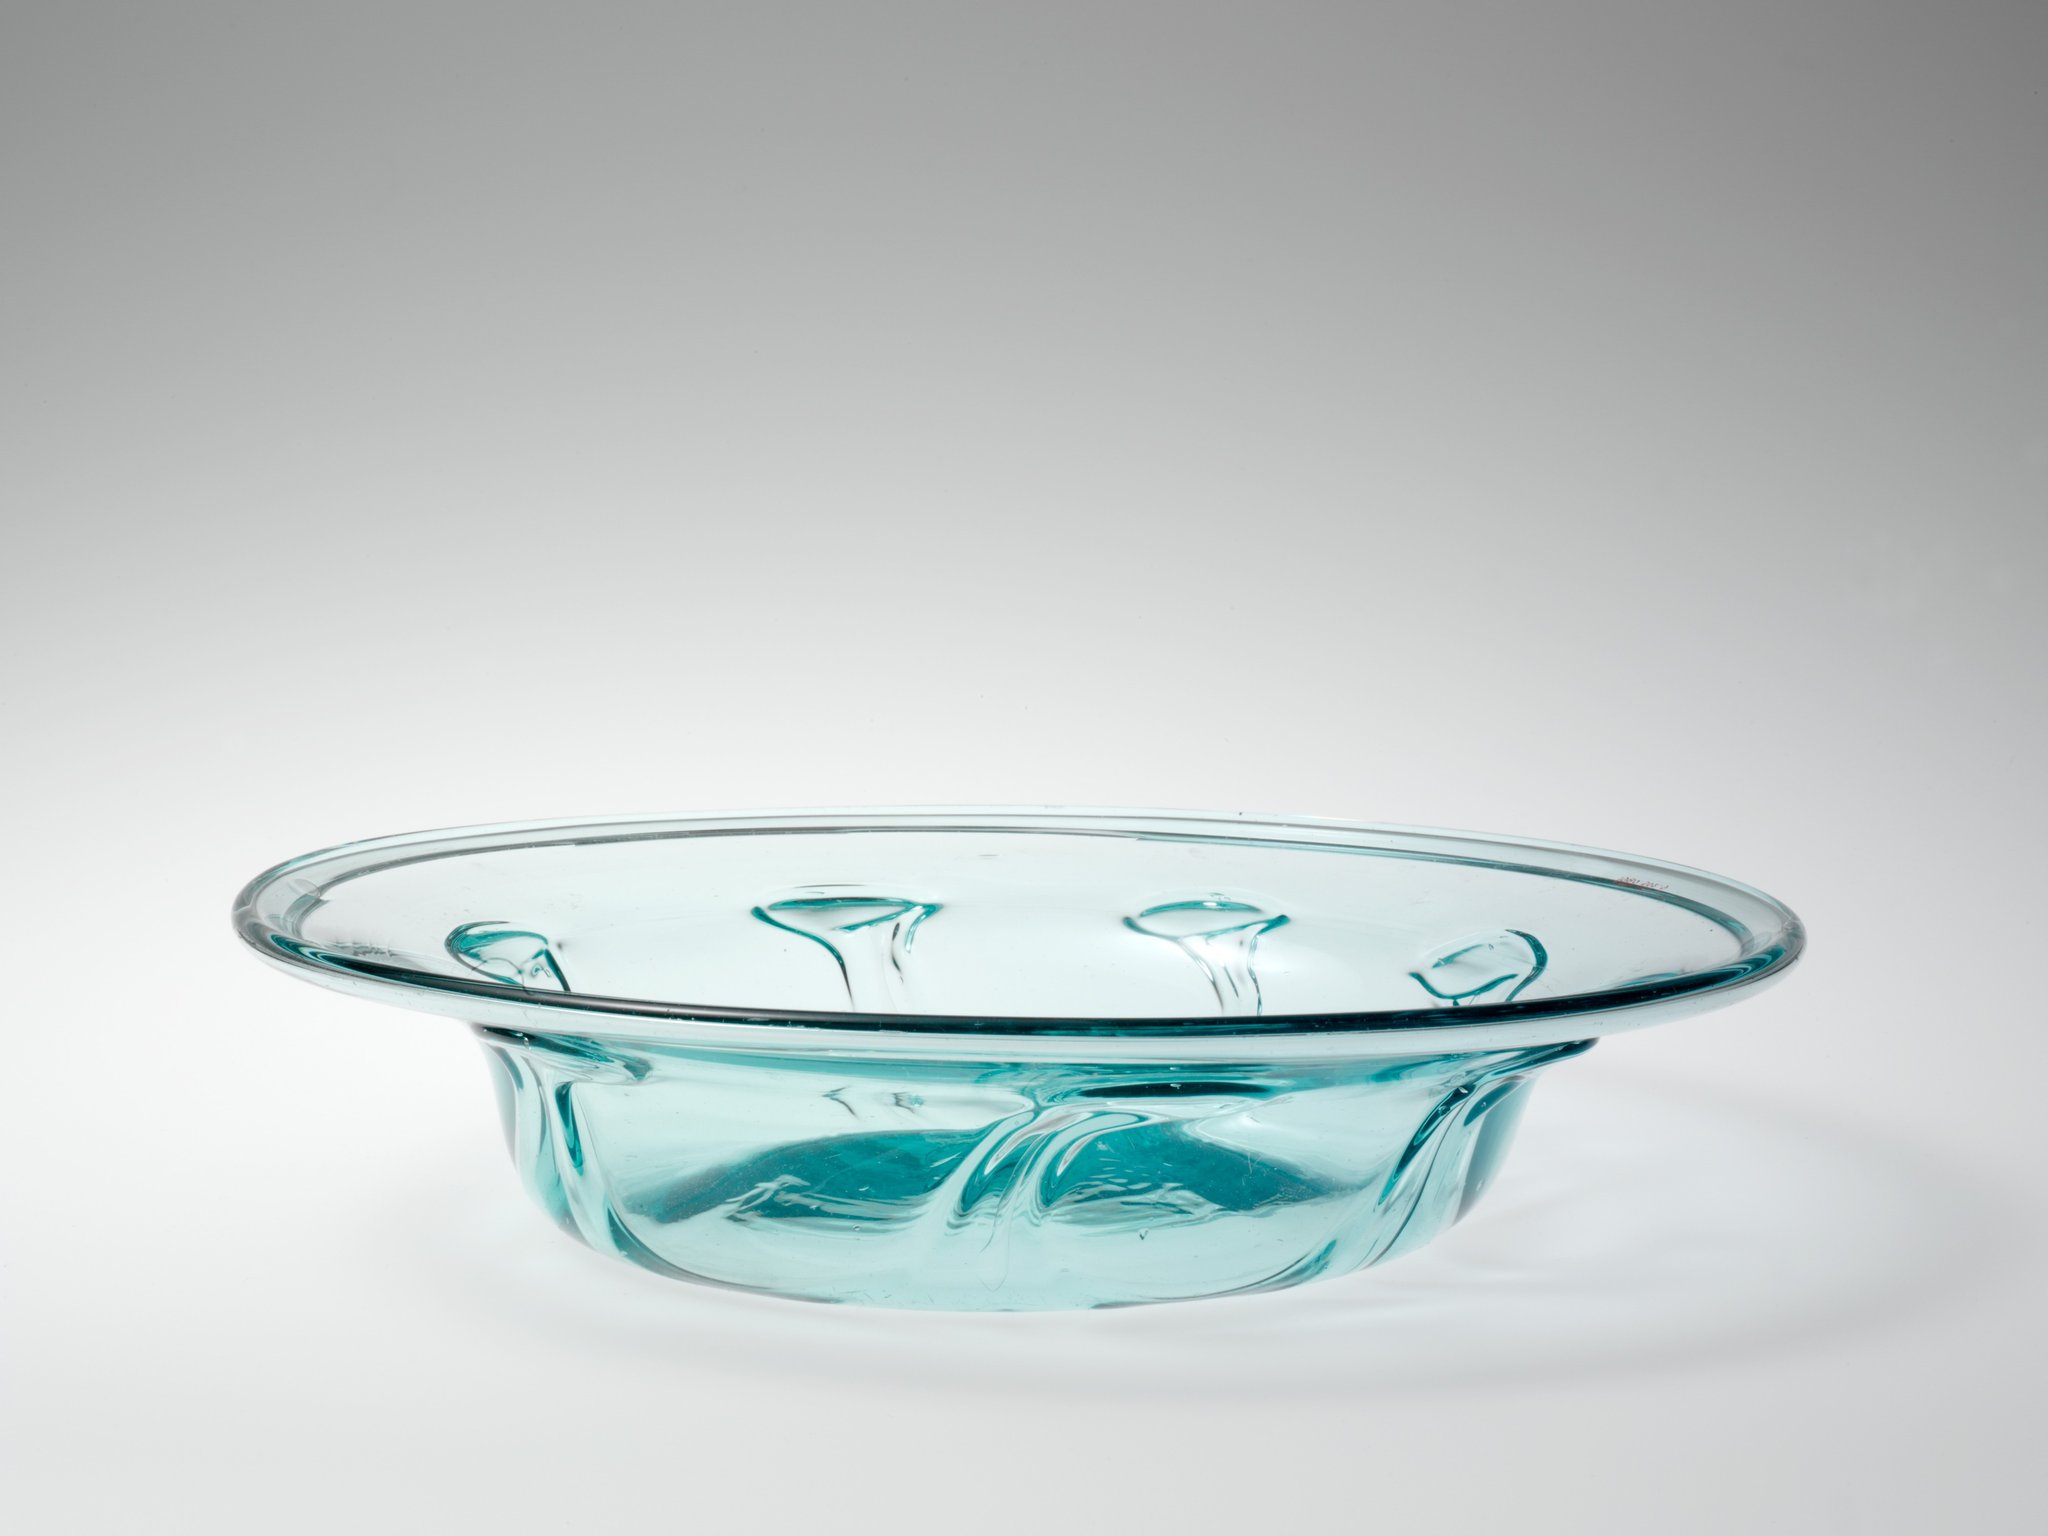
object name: pan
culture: american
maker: redwood glass company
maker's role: manufacturer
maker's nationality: american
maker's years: 1828-1868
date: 1835-1865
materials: glass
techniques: glassblowing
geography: united states